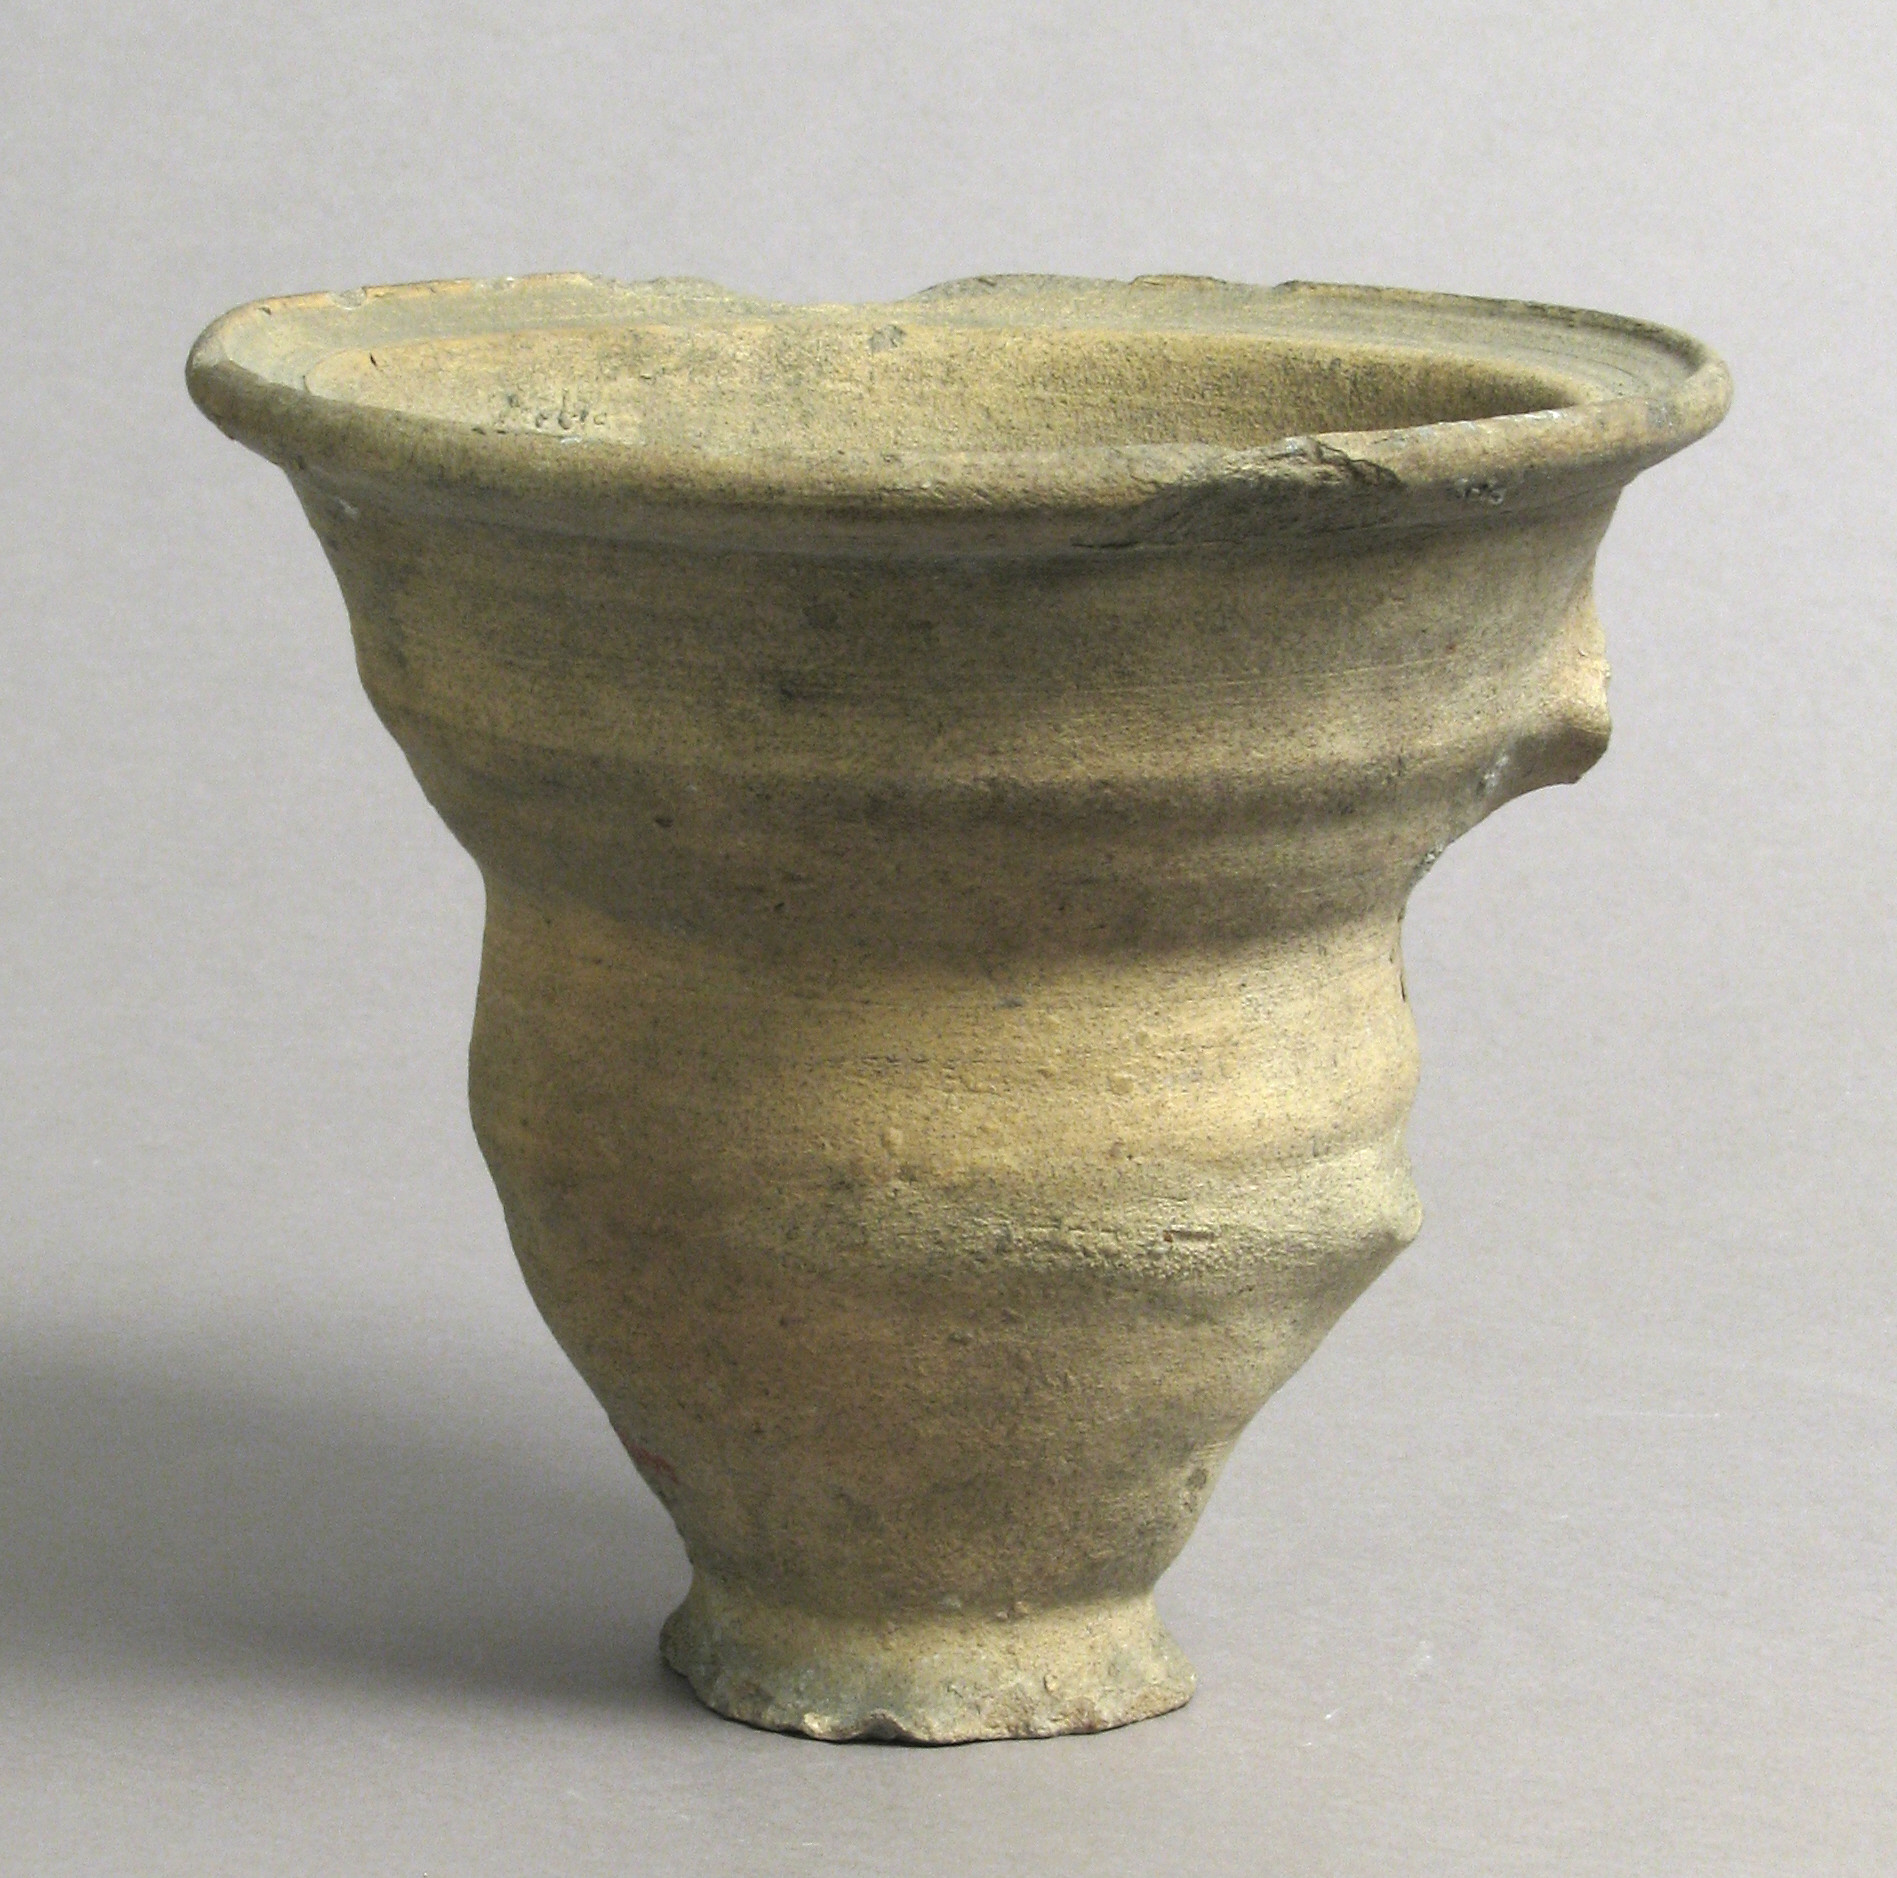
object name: jar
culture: french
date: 1401-1600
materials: earthenware